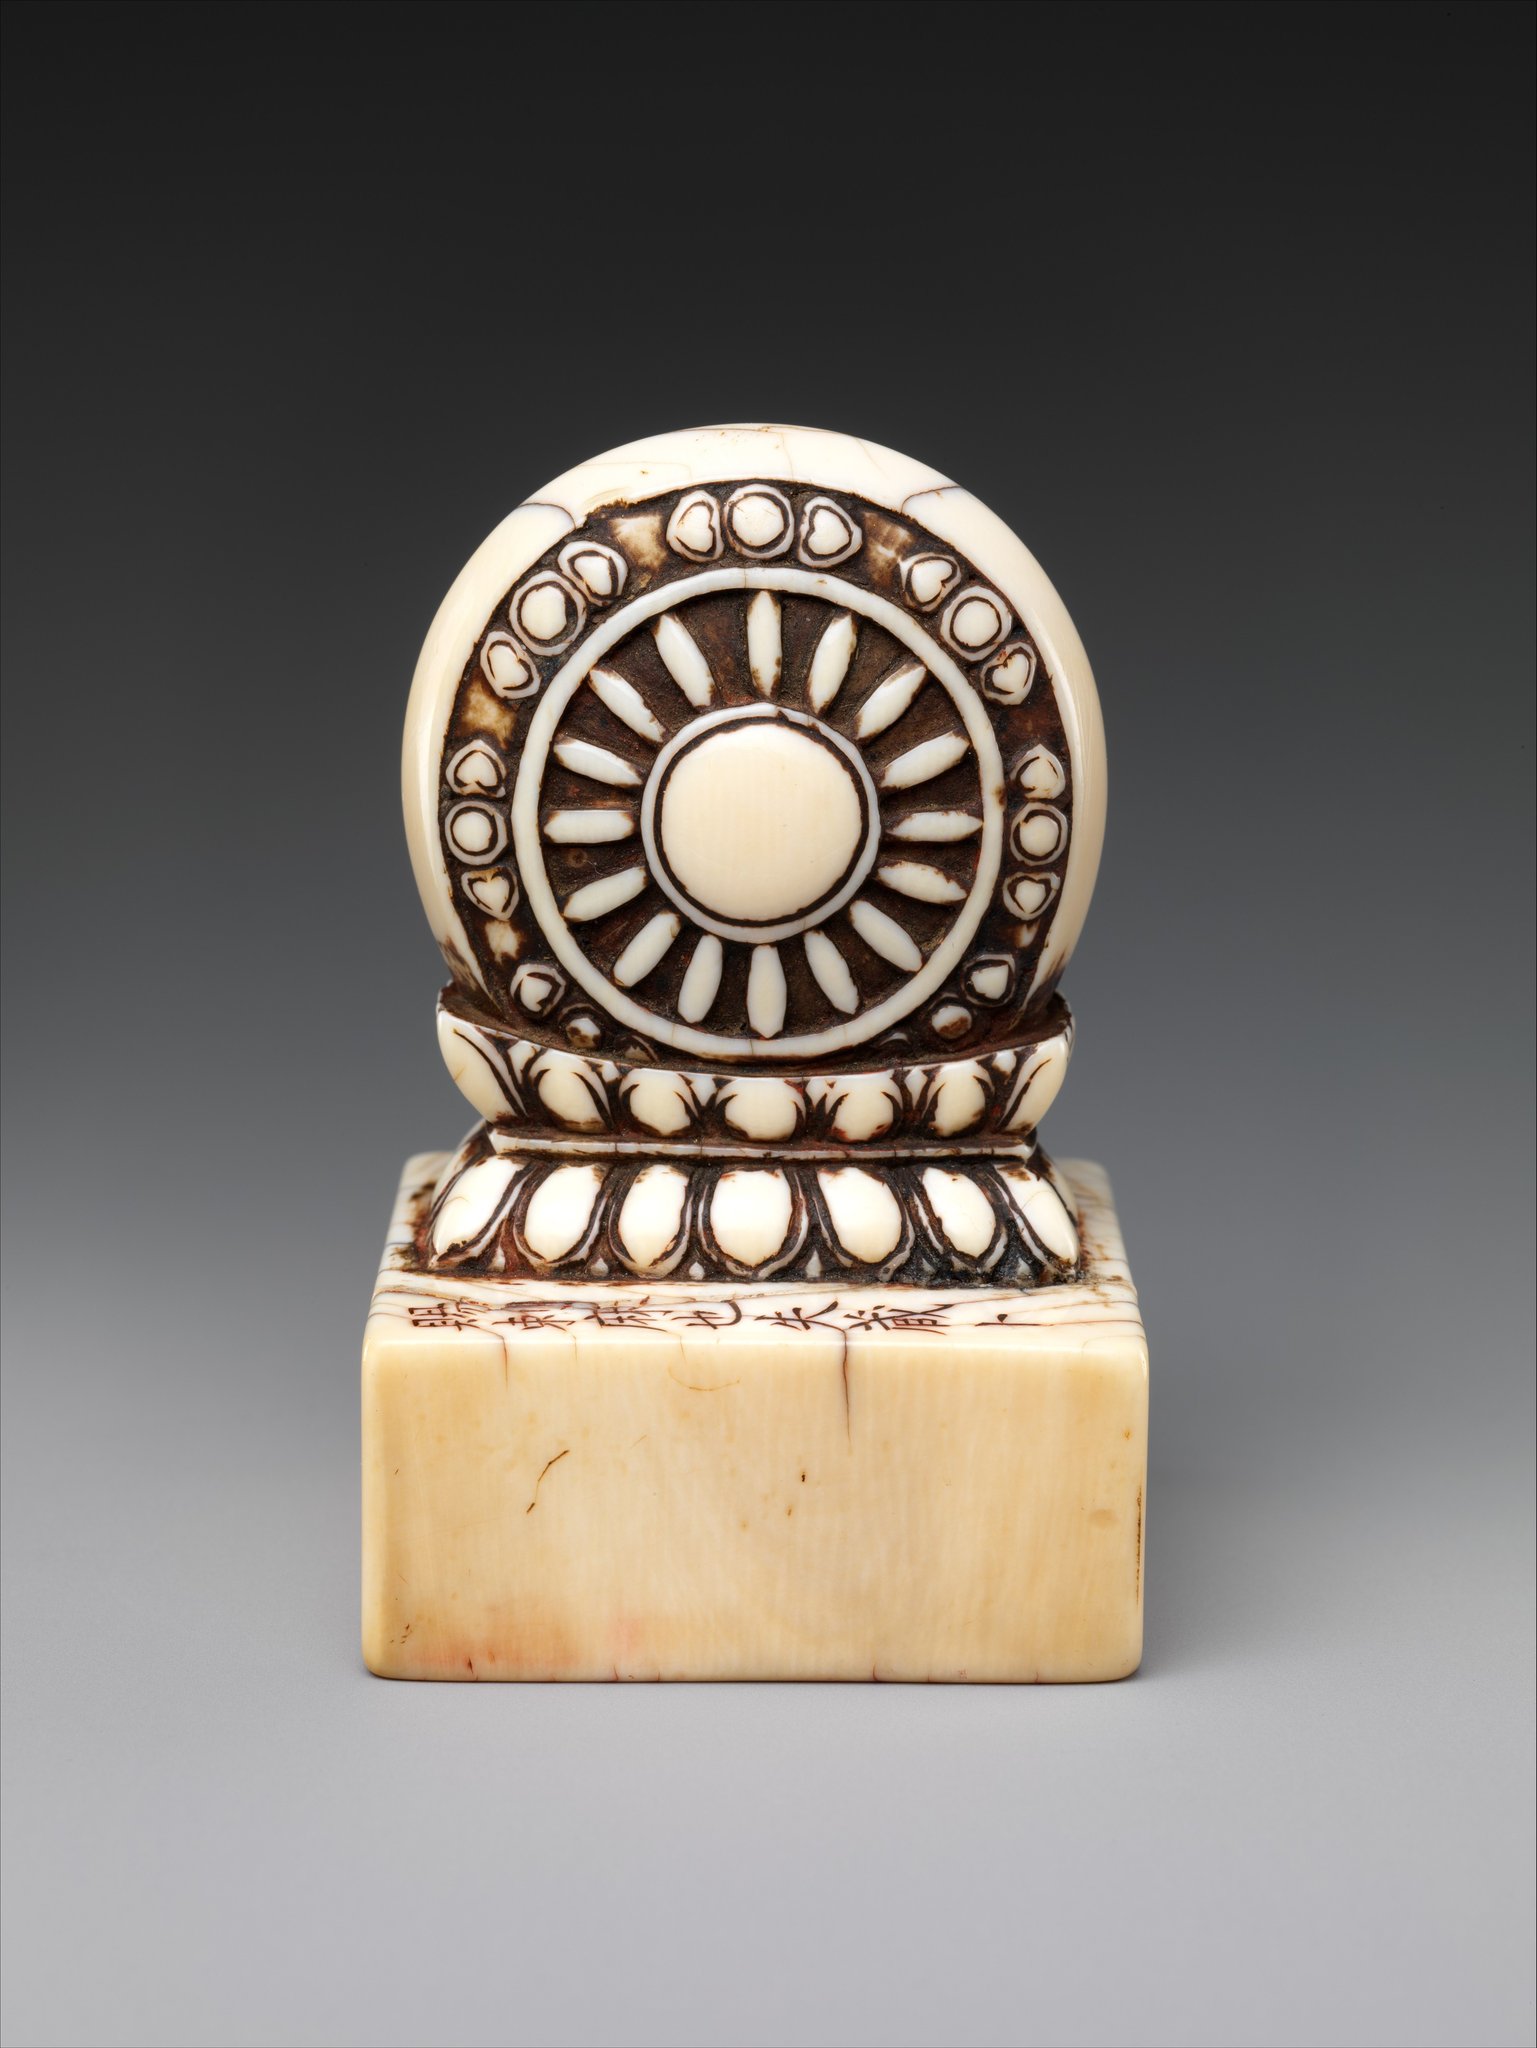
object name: seal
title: Seal with knob in the shape of a wheel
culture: chinese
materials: ivory